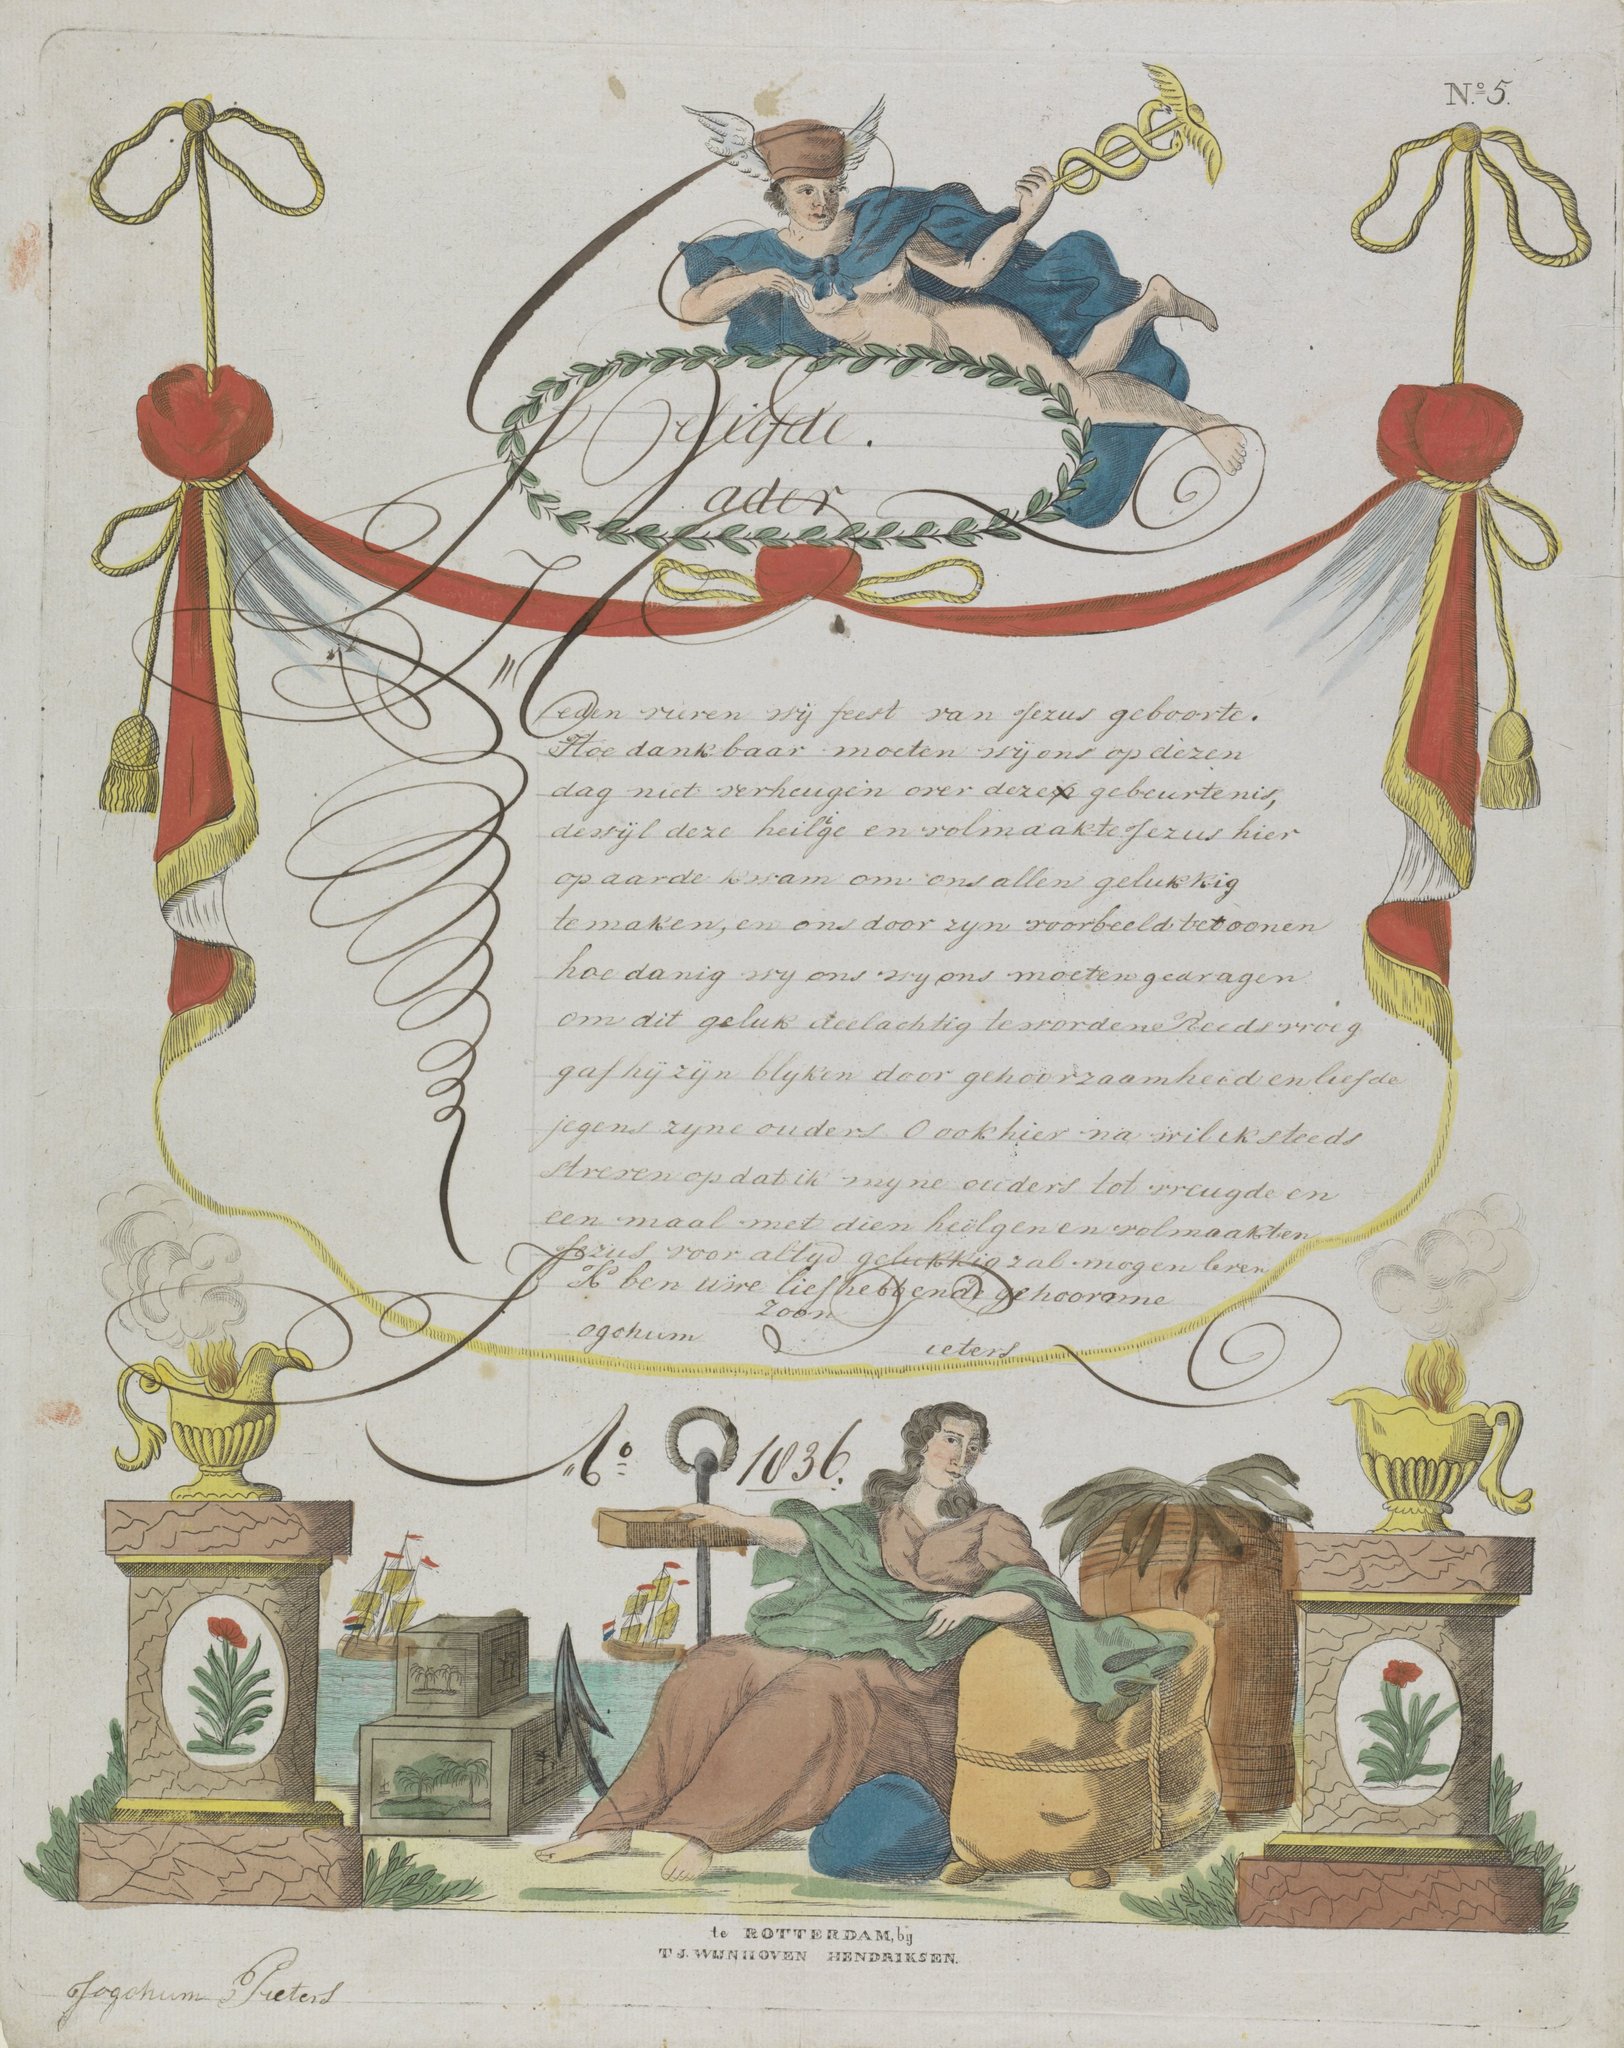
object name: wensbrief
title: Wensbrief met Mercurius en Hoop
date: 1812-1849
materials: ink, paper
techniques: calligraphy, colour, etching, pen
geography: rotterdam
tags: hope, 'spes'; 'speranza divina e certa' (ripa) ~ one of the three theological virtues, (story of) mercury (hermes)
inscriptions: inscription: ‘Geliefde vader / Heden vieren wij feest van Jezus geboorte ...’, collector's mark: Lugt 2760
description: Wensbrief met beschreven cartouche binnen een decoratief kader met voorstellingen van Mercurius en van Hoop (op een behouden vaart), een vrouw met anker in de haven. Handgeschreven bericht in kalligrafie door Jogchum Pieters aan zijn vader. Genummerd rechtsboven: No. 5.